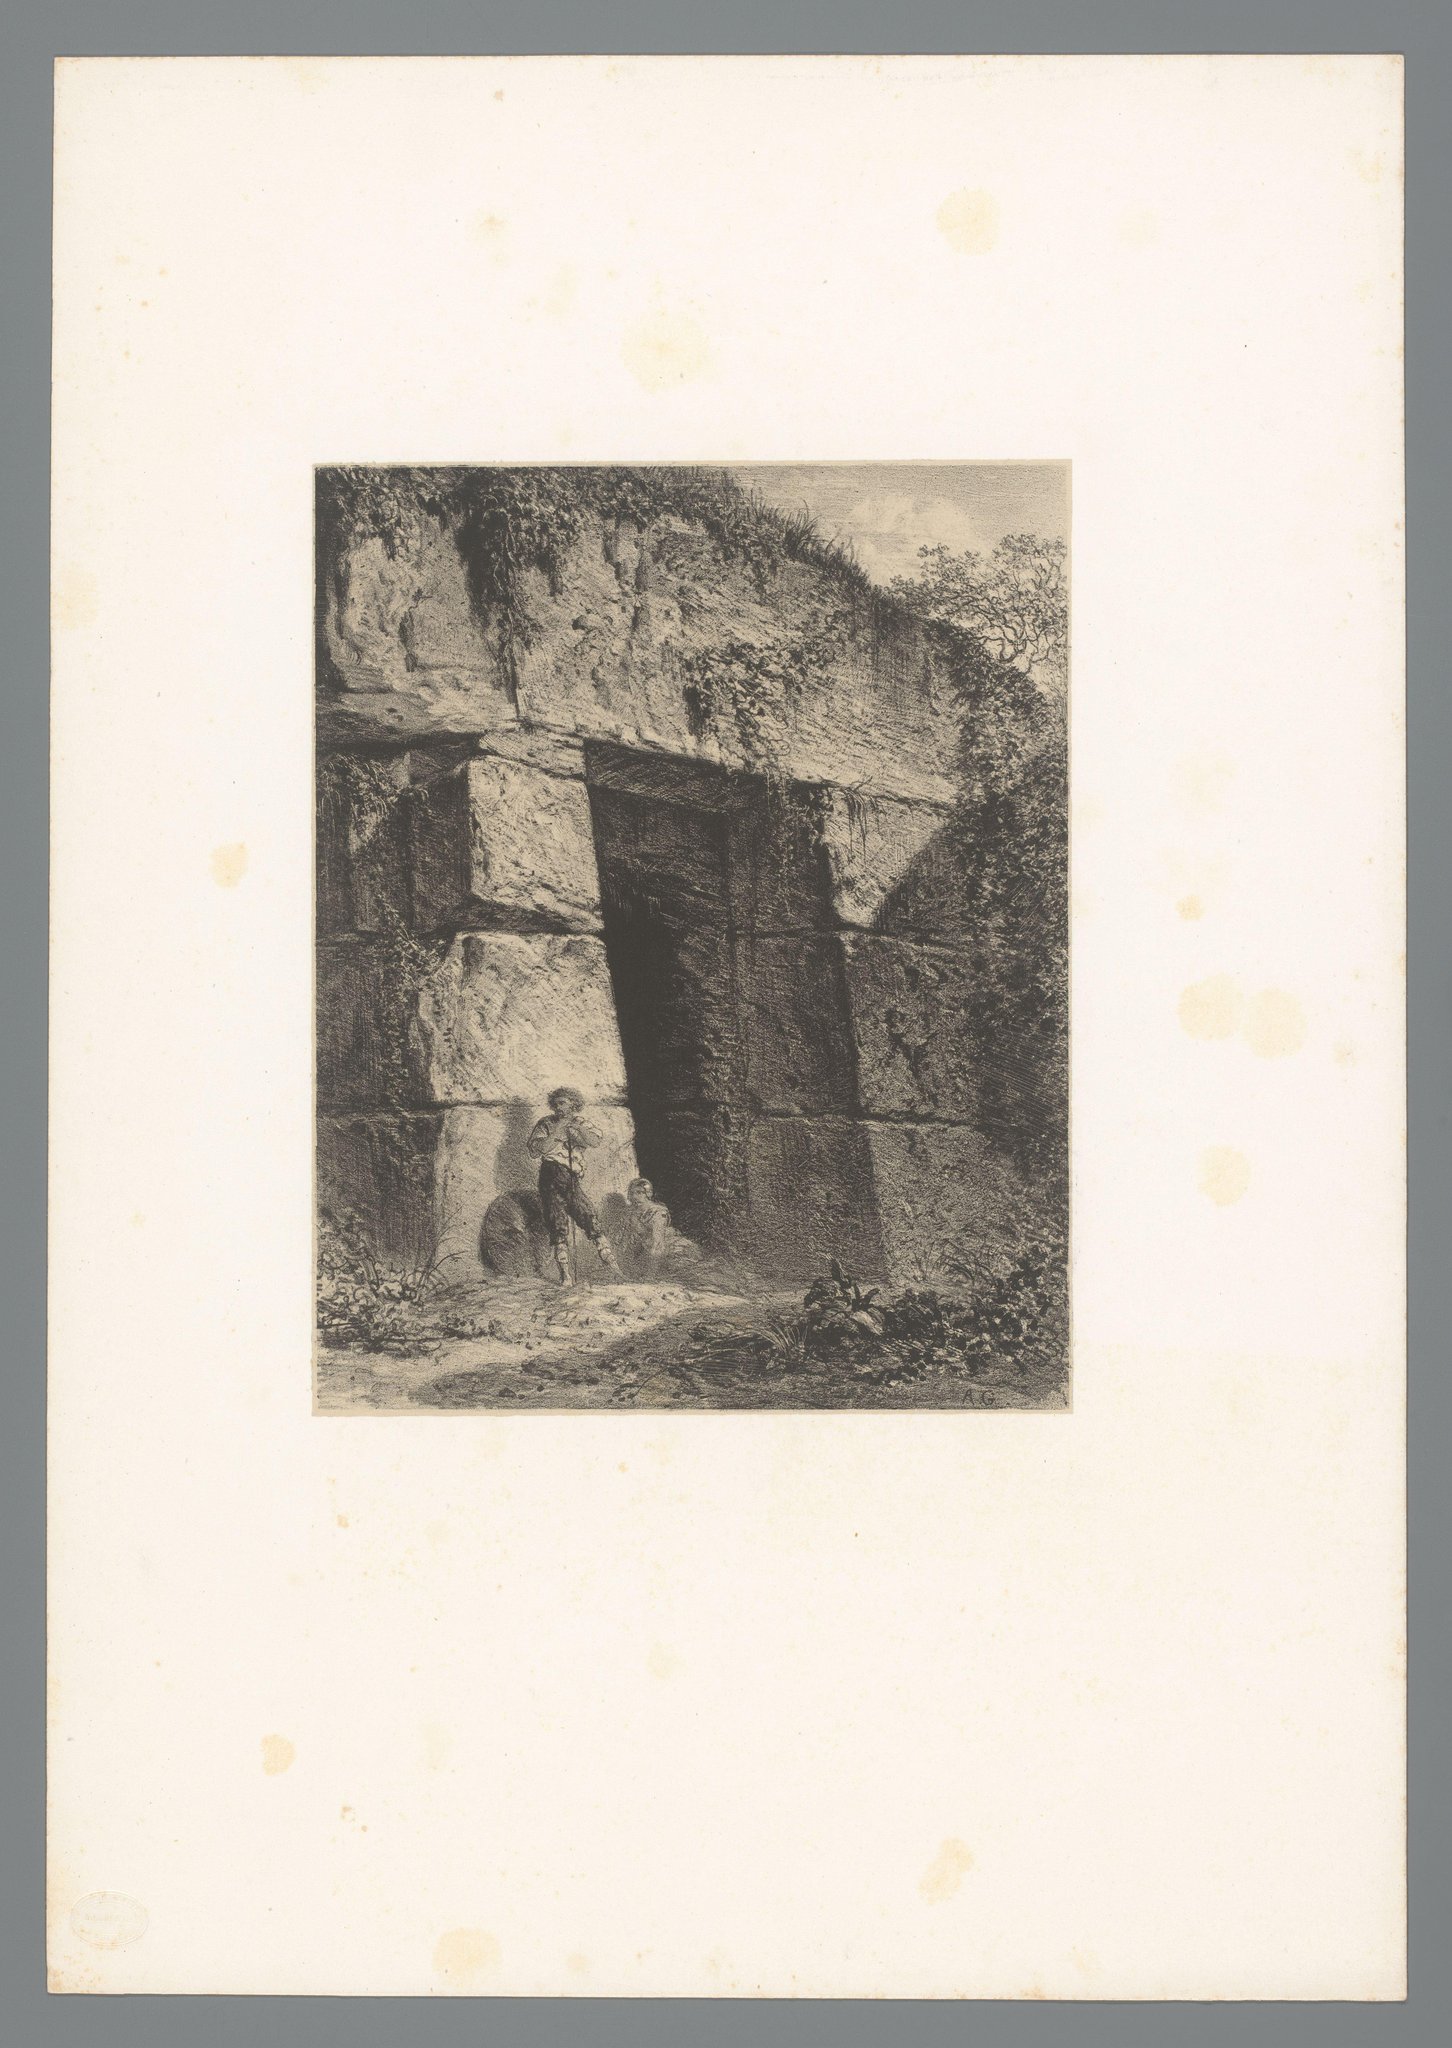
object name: print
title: Ingang van rotstunnel met wachters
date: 1847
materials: paper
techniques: lithograph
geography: paris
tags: guard duty, keeping sentry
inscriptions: collector's mark: Lugt 964, check stamp: Lugt 4801